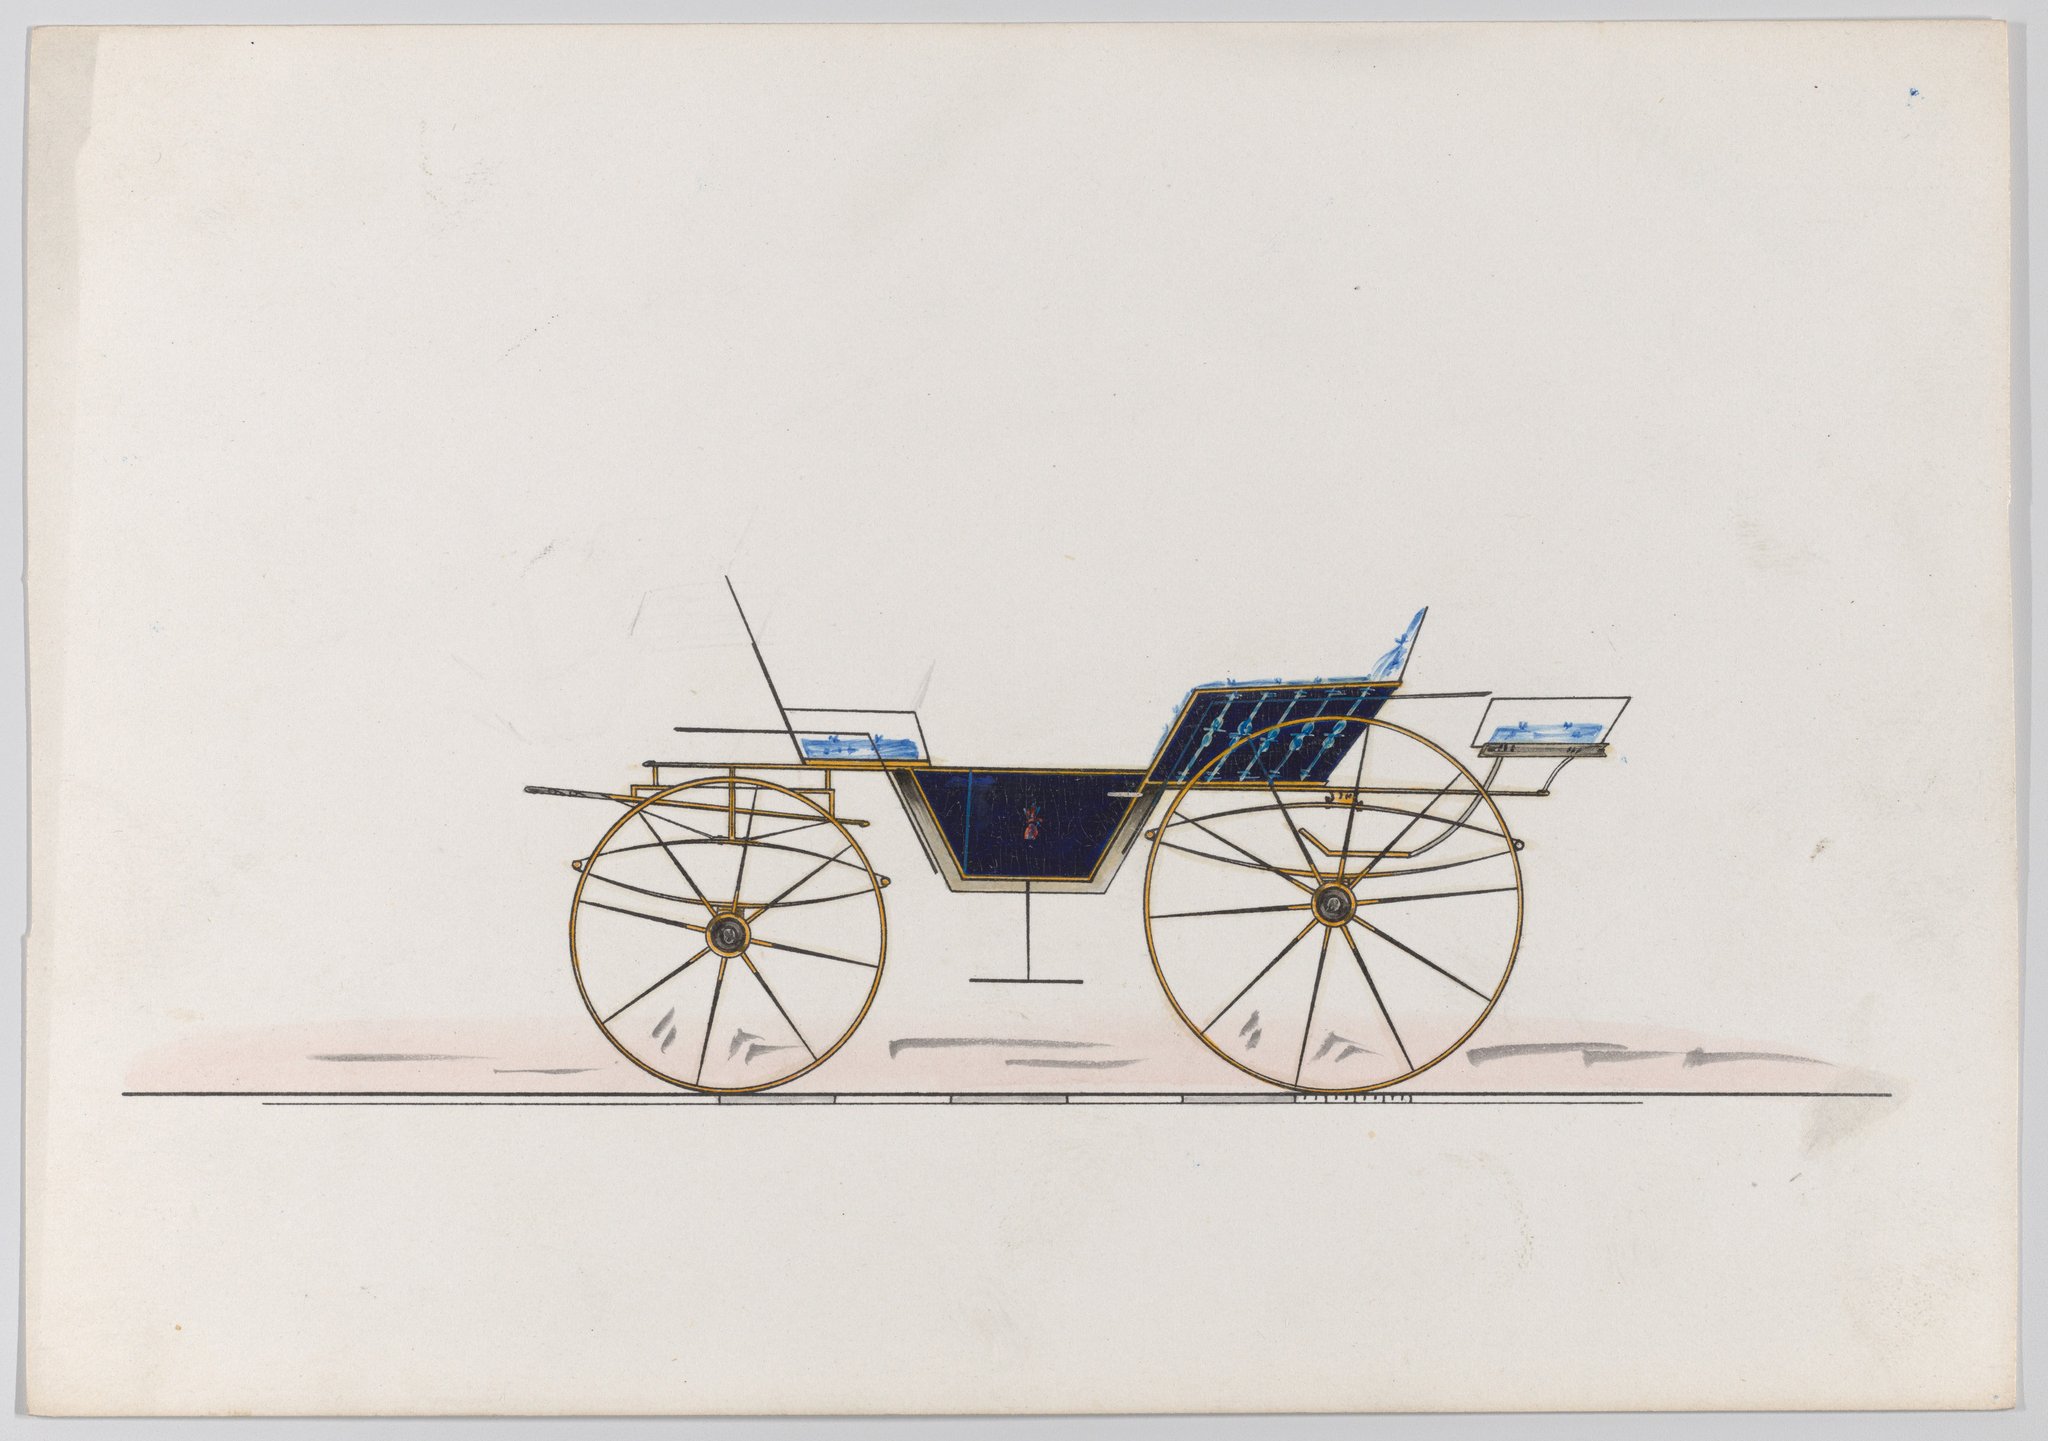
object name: drawing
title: Design for Vis-à-vis Phaeton (unnumbered)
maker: brewster & co.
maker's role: manufacturer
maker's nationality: american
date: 1870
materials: gouache, gum arabic, ink, watercolor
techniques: pen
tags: carriages